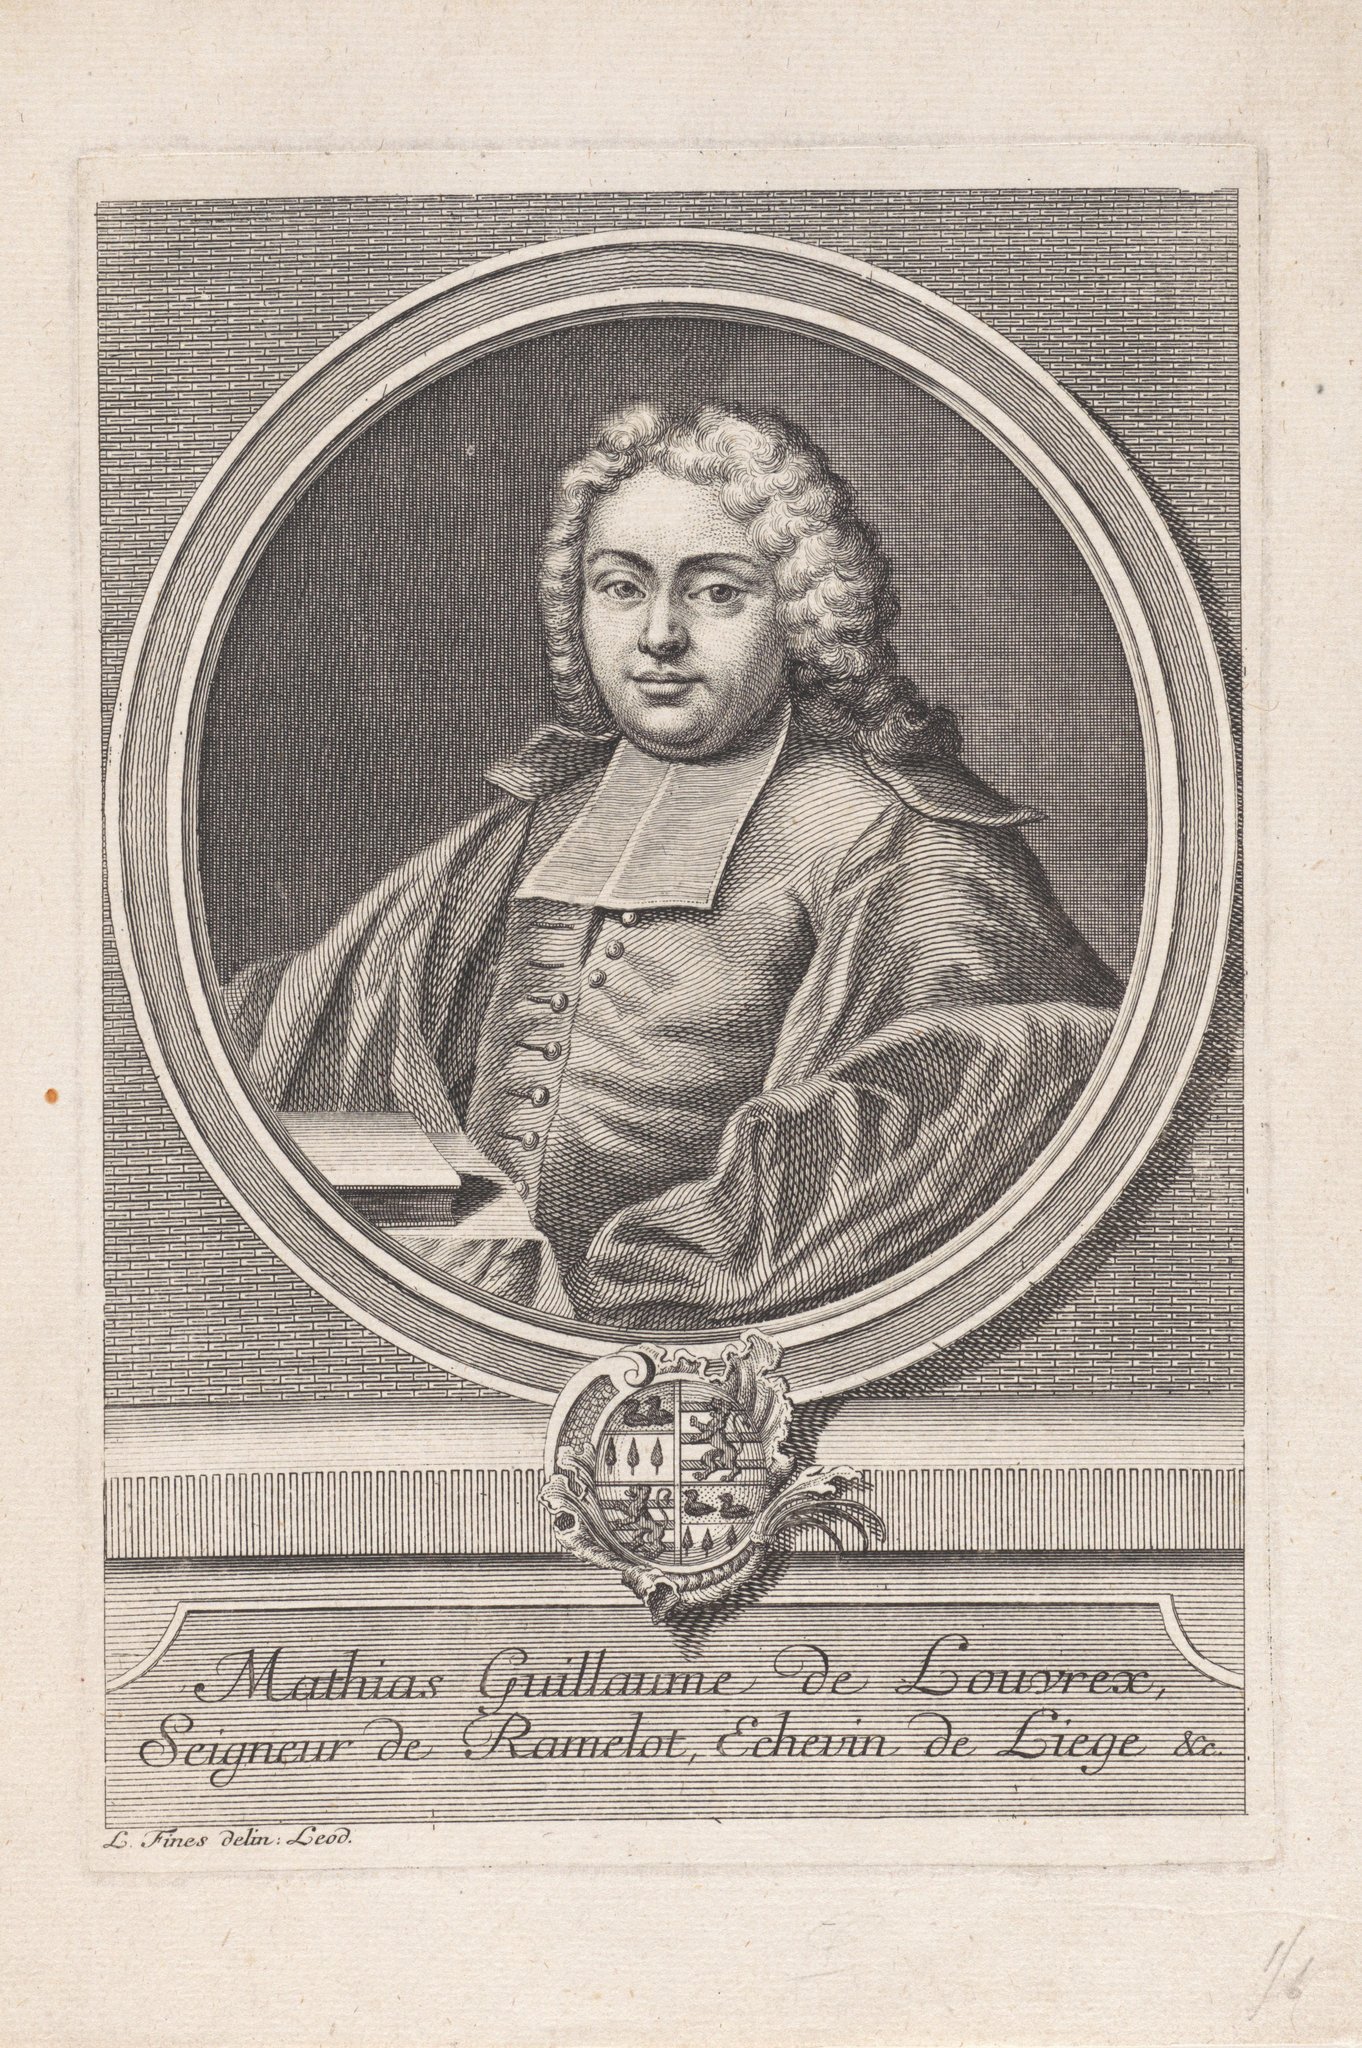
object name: print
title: Portret van Mathias-Guillaume de Louvrex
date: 1680-1734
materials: paper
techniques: engraving, etching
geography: liège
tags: historical persons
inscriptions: collector's mark: Lugt 2228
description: Buste van de diplomaat Mathias-Guillaume de Louvrex met bef. Voor hem ligt een boek op tafel. Onder de ovale omlijsting is een wapen te zien.